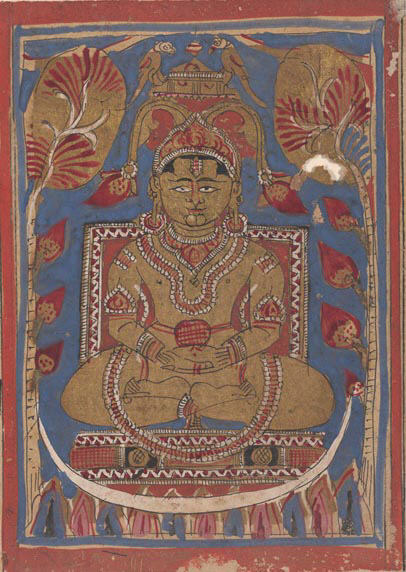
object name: folio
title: Mahavira Sitting at the Top of the Universe: Folio from a Kalpasutra Manuscript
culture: indian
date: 1401-1500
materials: gold, ink, paper, watercolor